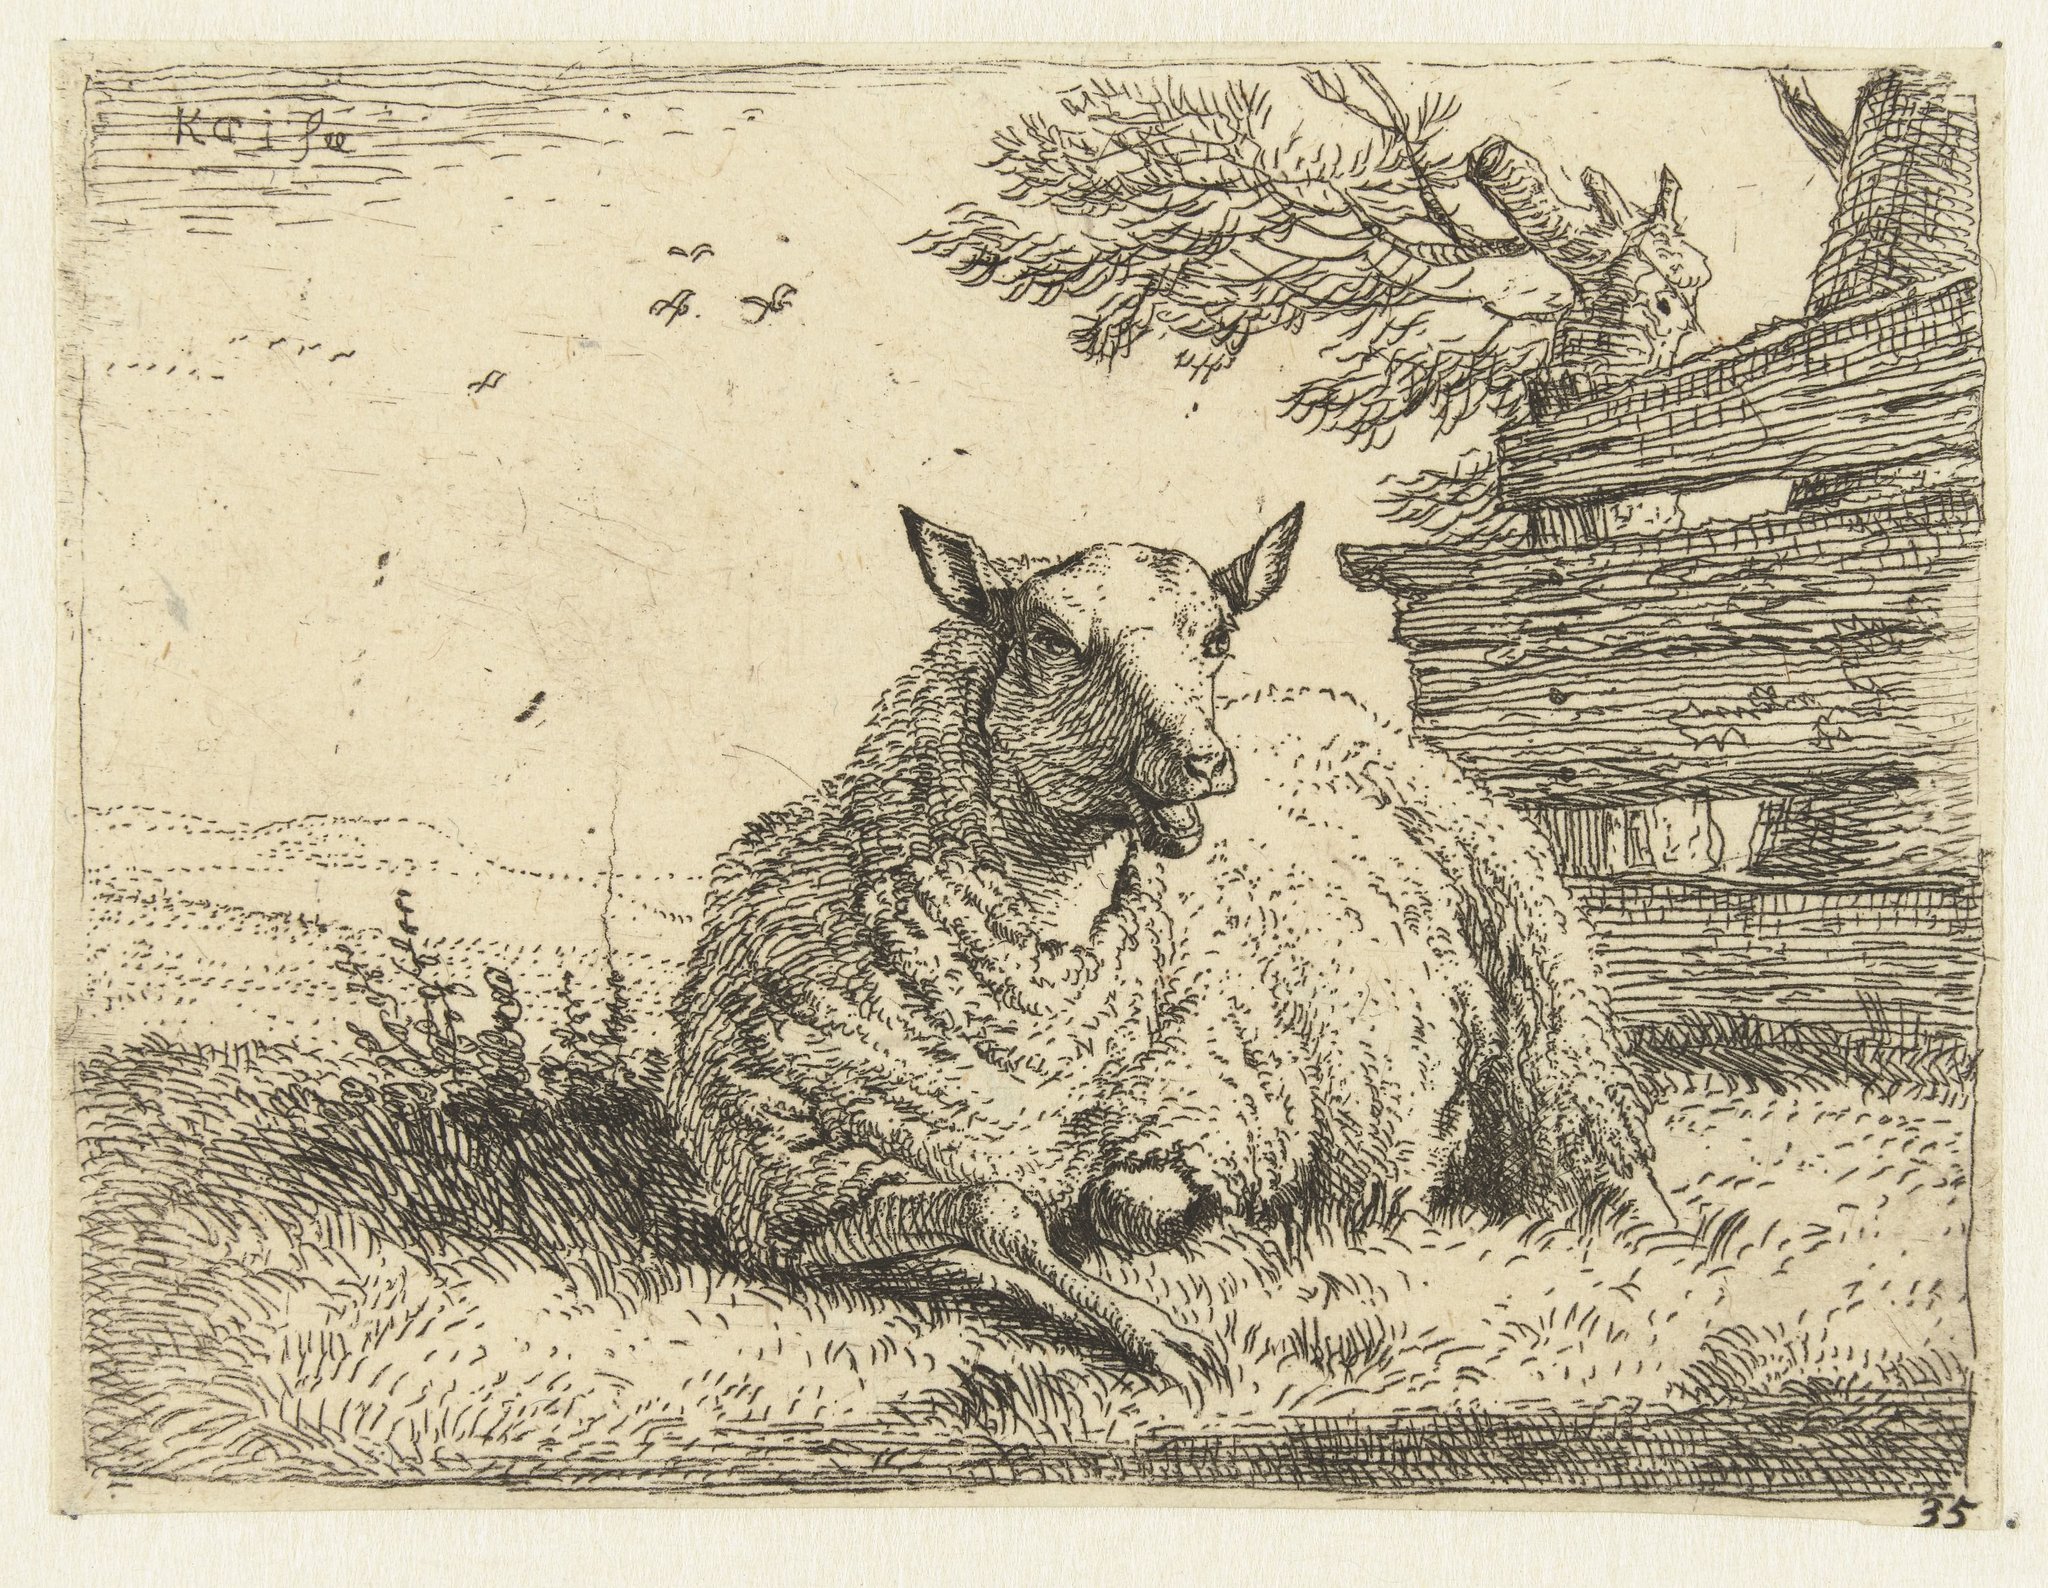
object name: print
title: Schaap bij een hek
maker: karel du jardin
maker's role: draughtsman, painter, print maker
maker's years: 1626-1678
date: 1652-1659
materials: paper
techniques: etching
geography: netherlands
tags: sheep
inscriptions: collector's mark: Lugt 2228a